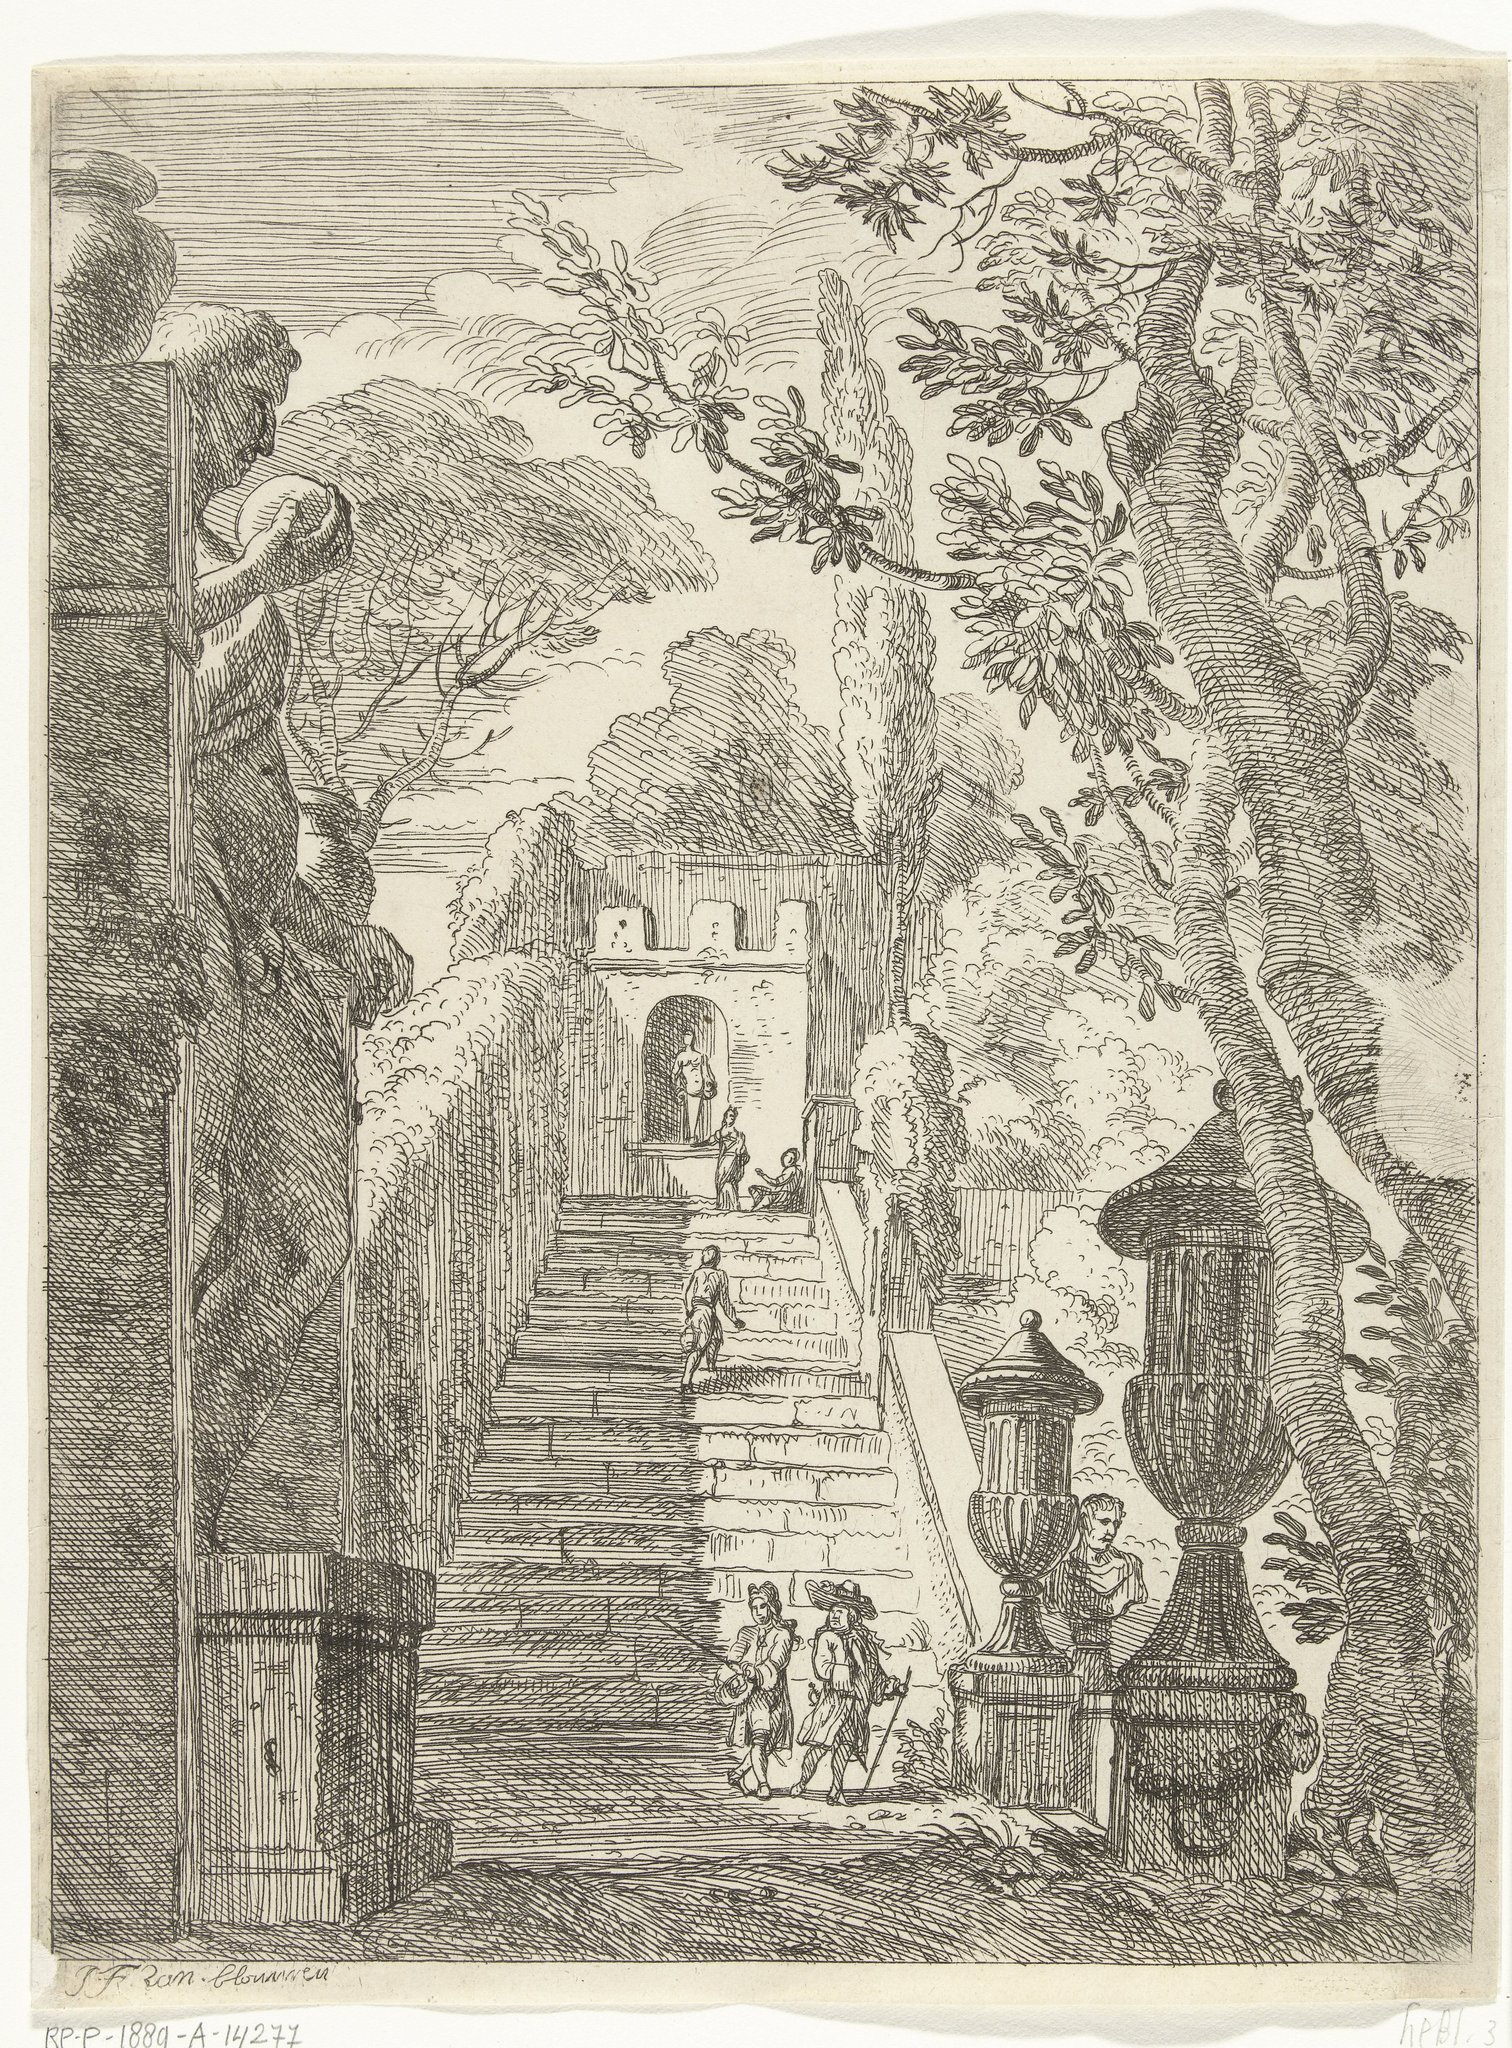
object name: print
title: Italianiserend landschap met wandelaars bij een trap in een tuin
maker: jan frans van bloemen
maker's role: draughtsman, print maker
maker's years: 1662-1749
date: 1689-1749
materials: paper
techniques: etching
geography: rome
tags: garden ornaments, public gardens, park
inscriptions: collector's mark: Lugt 2228